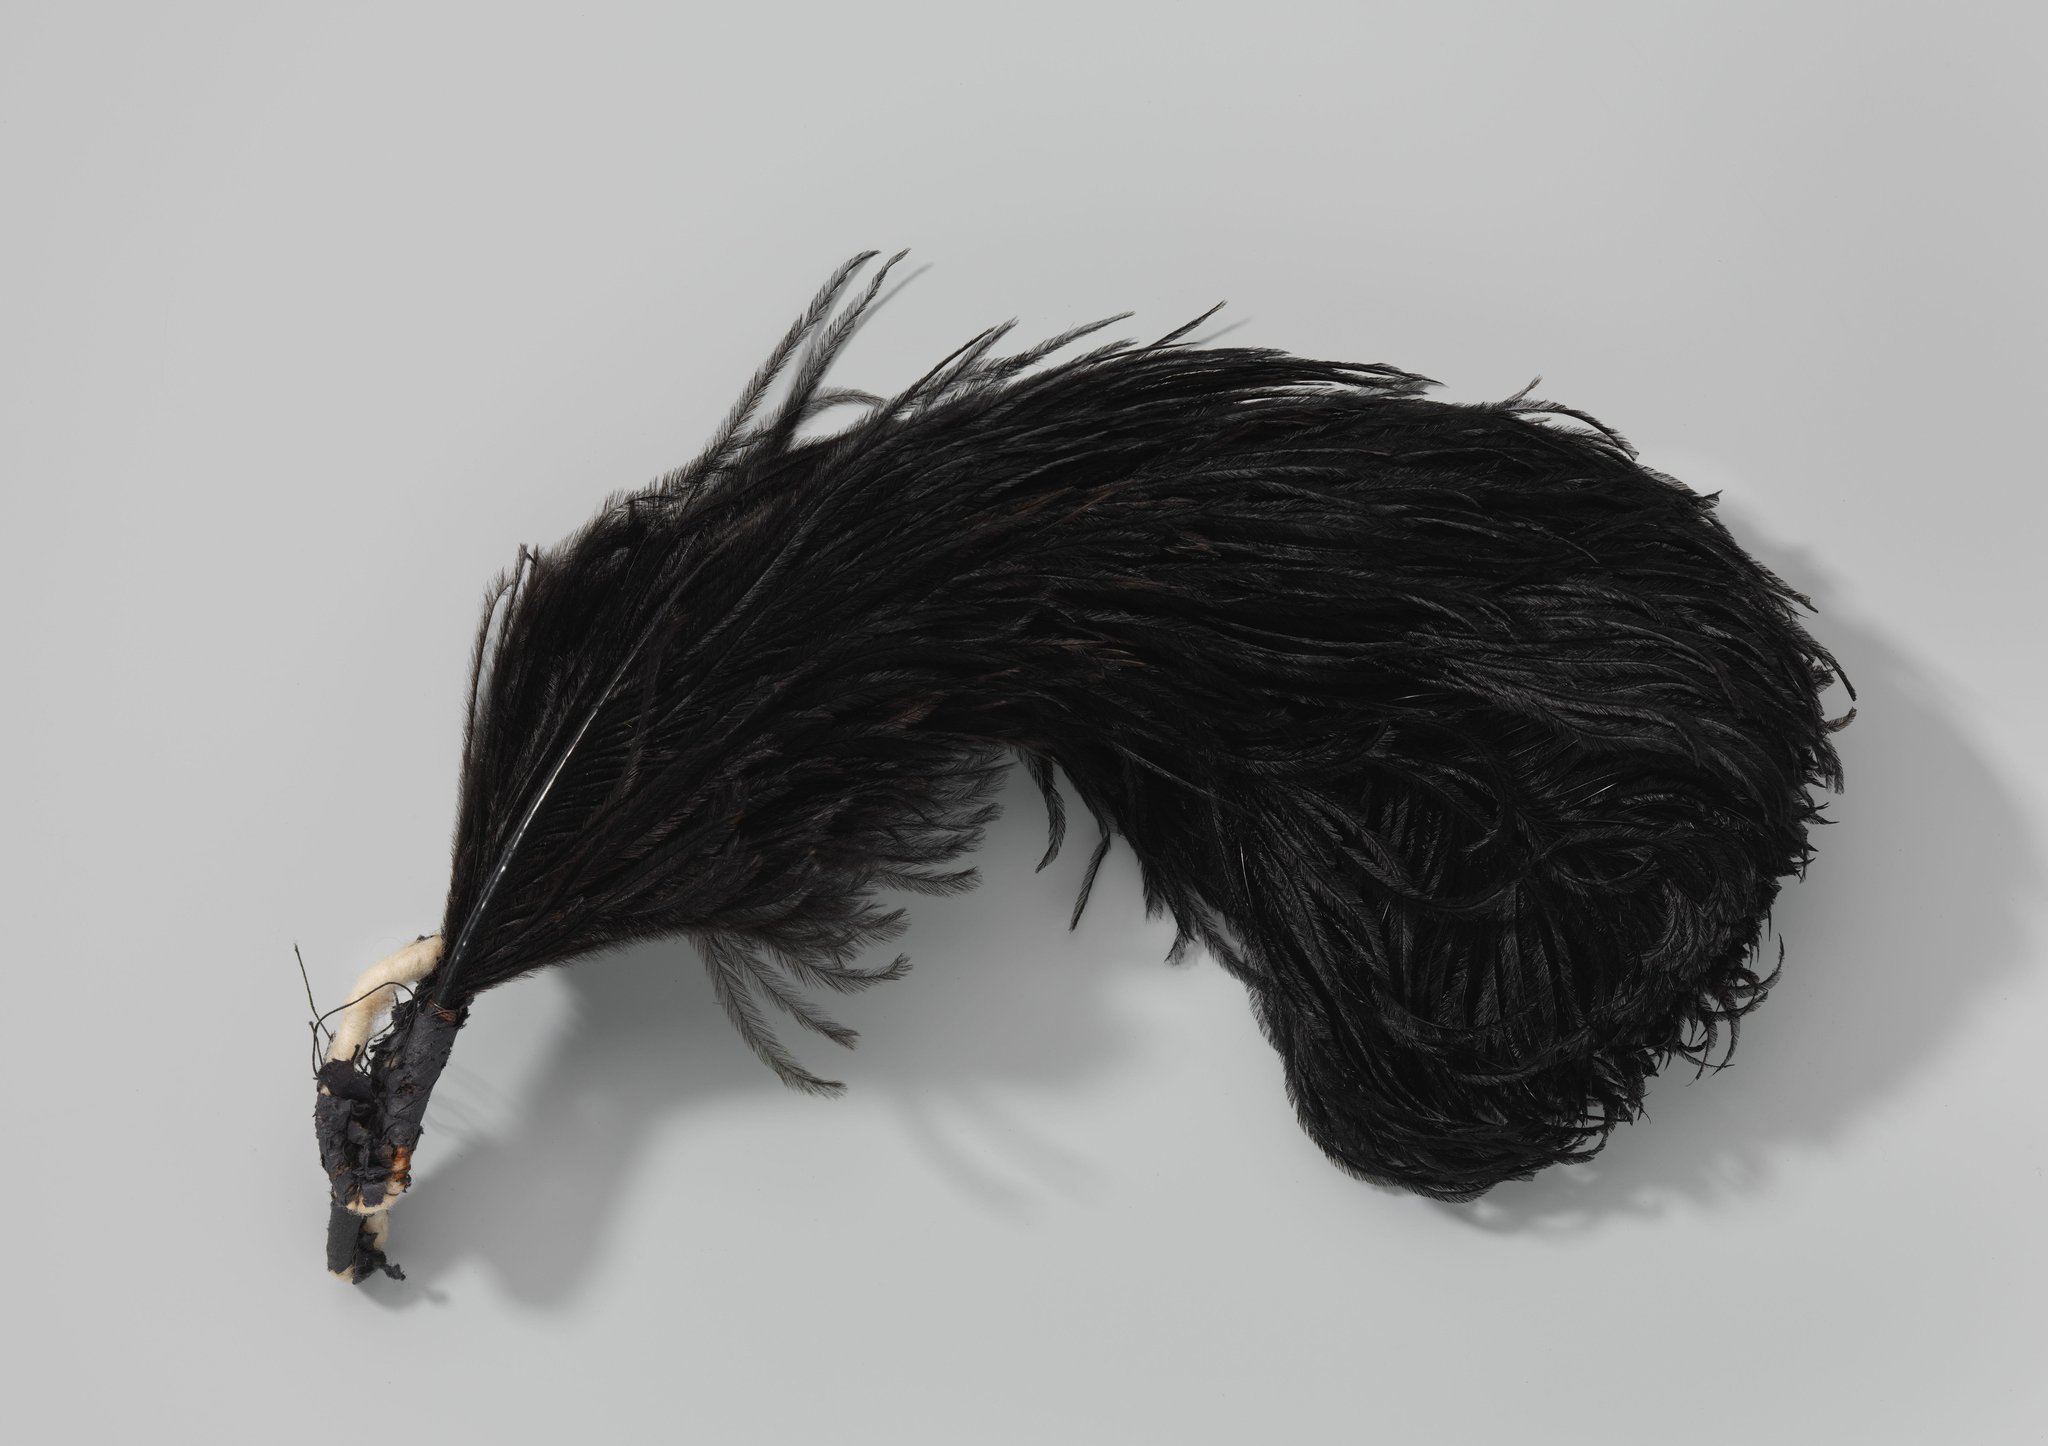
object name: hoedengarneersel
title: Toef struisveren, zwart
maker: Anonymous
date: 1880-1925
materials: metal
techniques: painting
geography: western europe